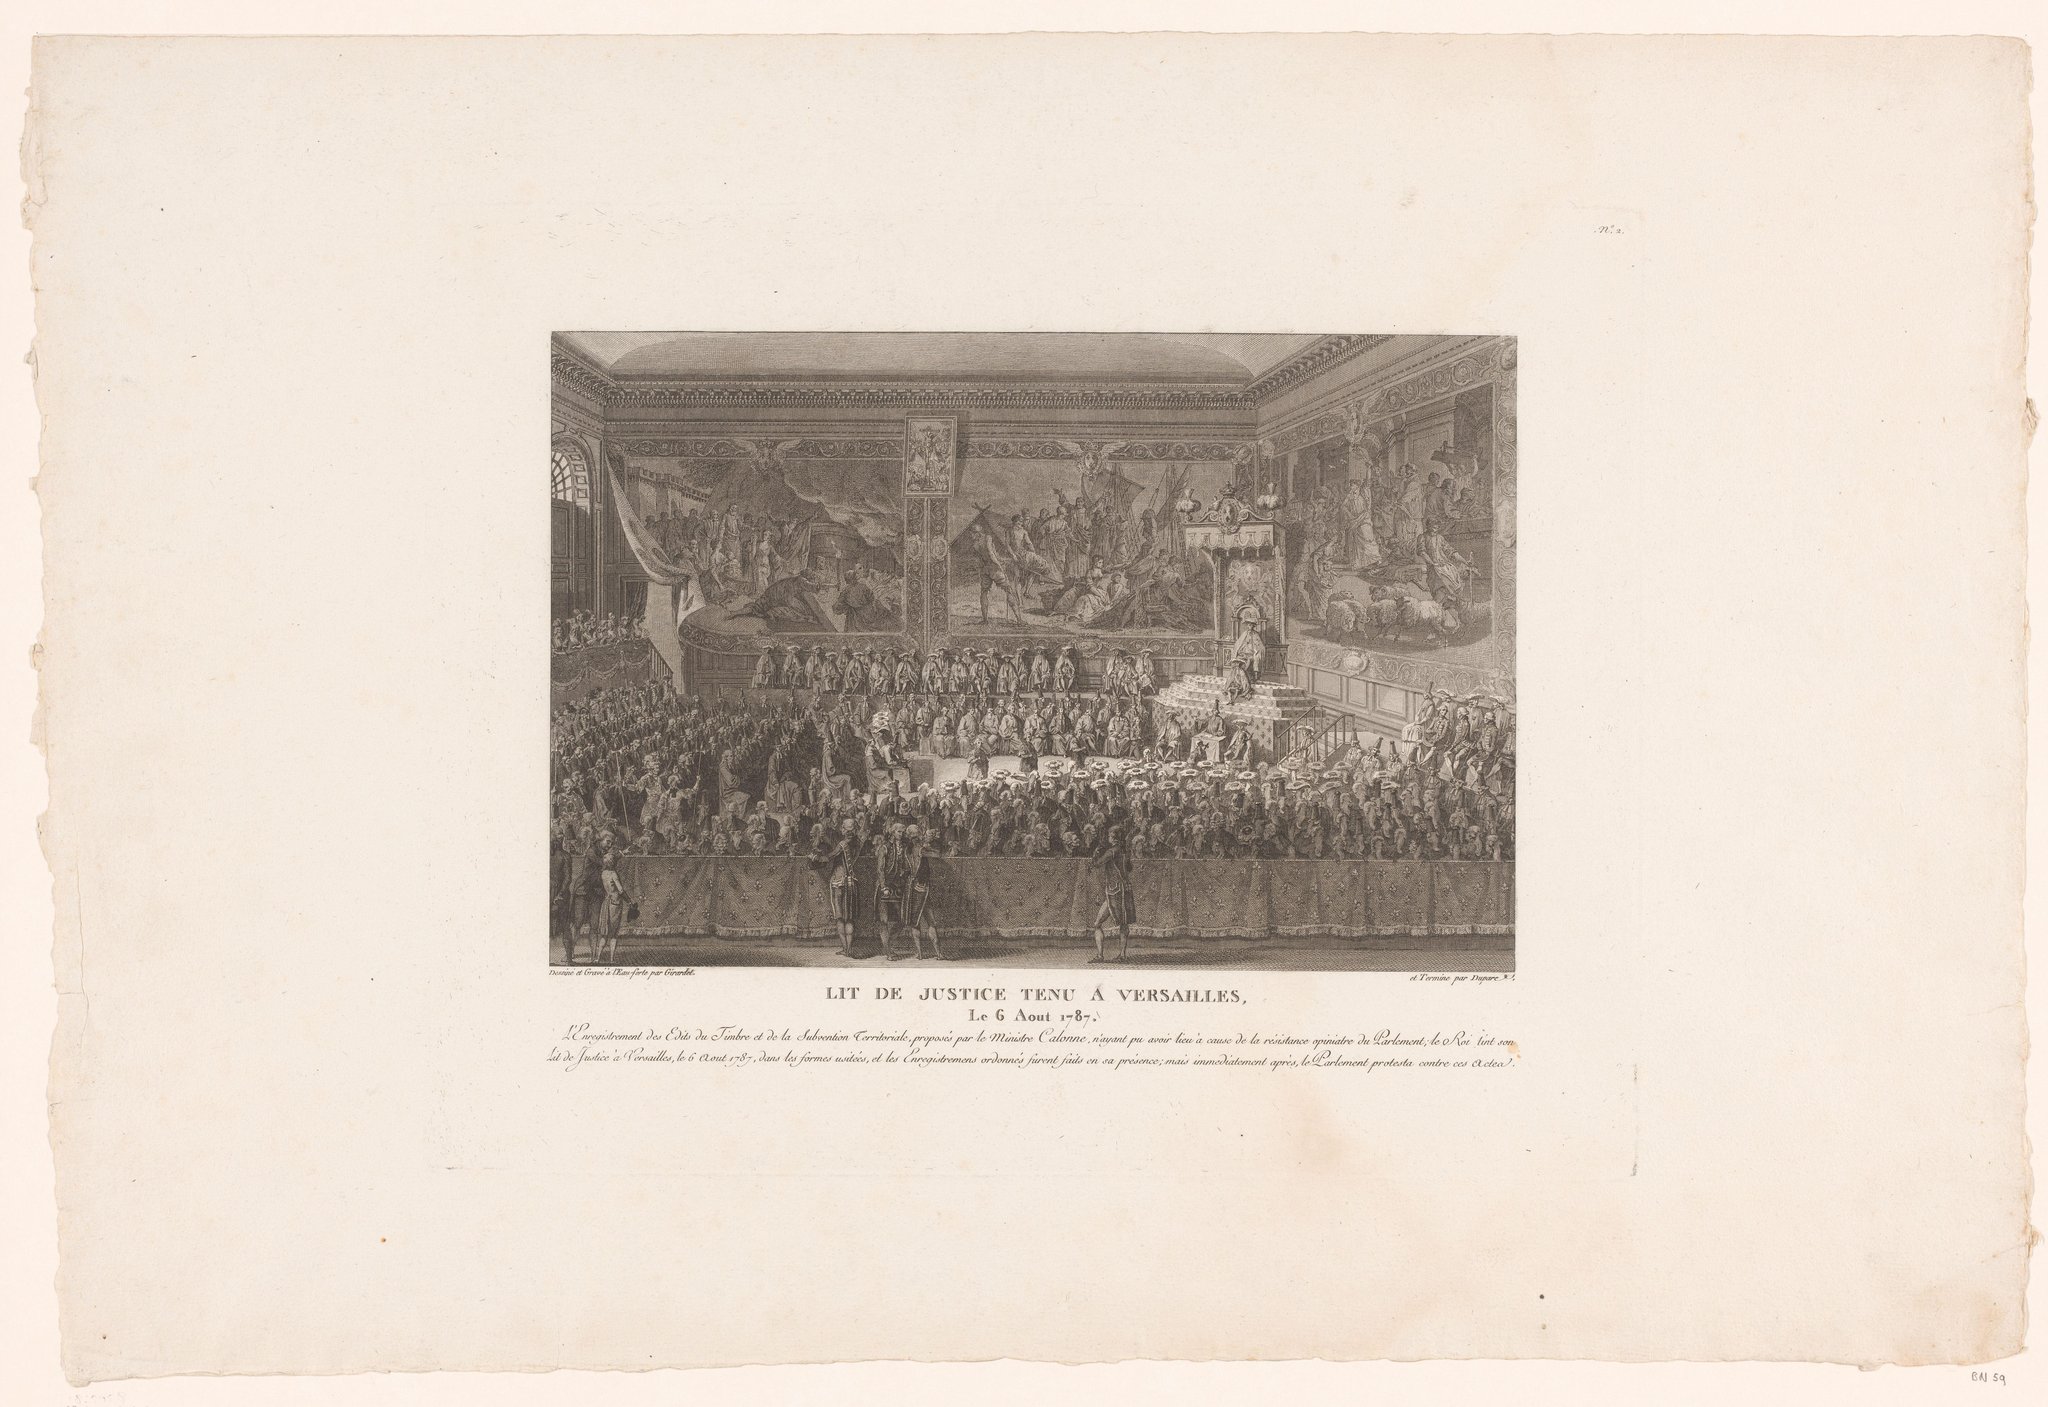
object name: print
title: Lit de justice tenu a Versailles, Le 6 Aout 1787.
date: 1792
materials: paper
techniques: etching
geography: paris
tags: court-room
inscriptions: collector's mark: Lugt 2233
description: Prent uit: Wicar, Jean-Baptiste Joseph. Tableaux, statues, bas-reliefs et camées, de la Galérie de Florence et du Palais Pitti (...). Parijs: Lacombe, 1792, dl. 2.